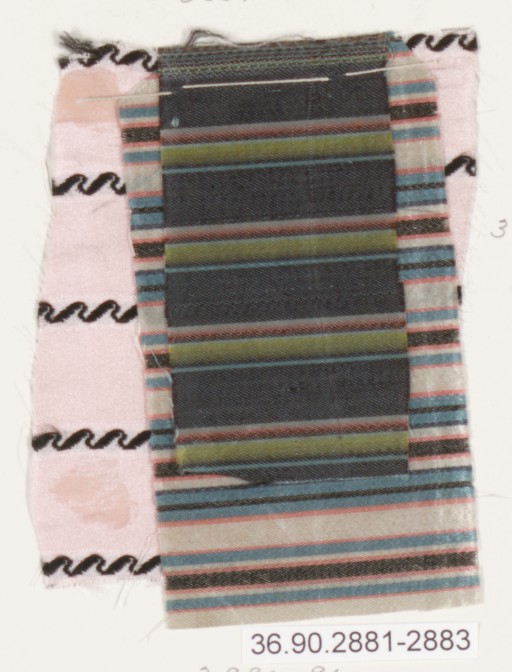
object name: piece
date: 1801-1900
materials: silk